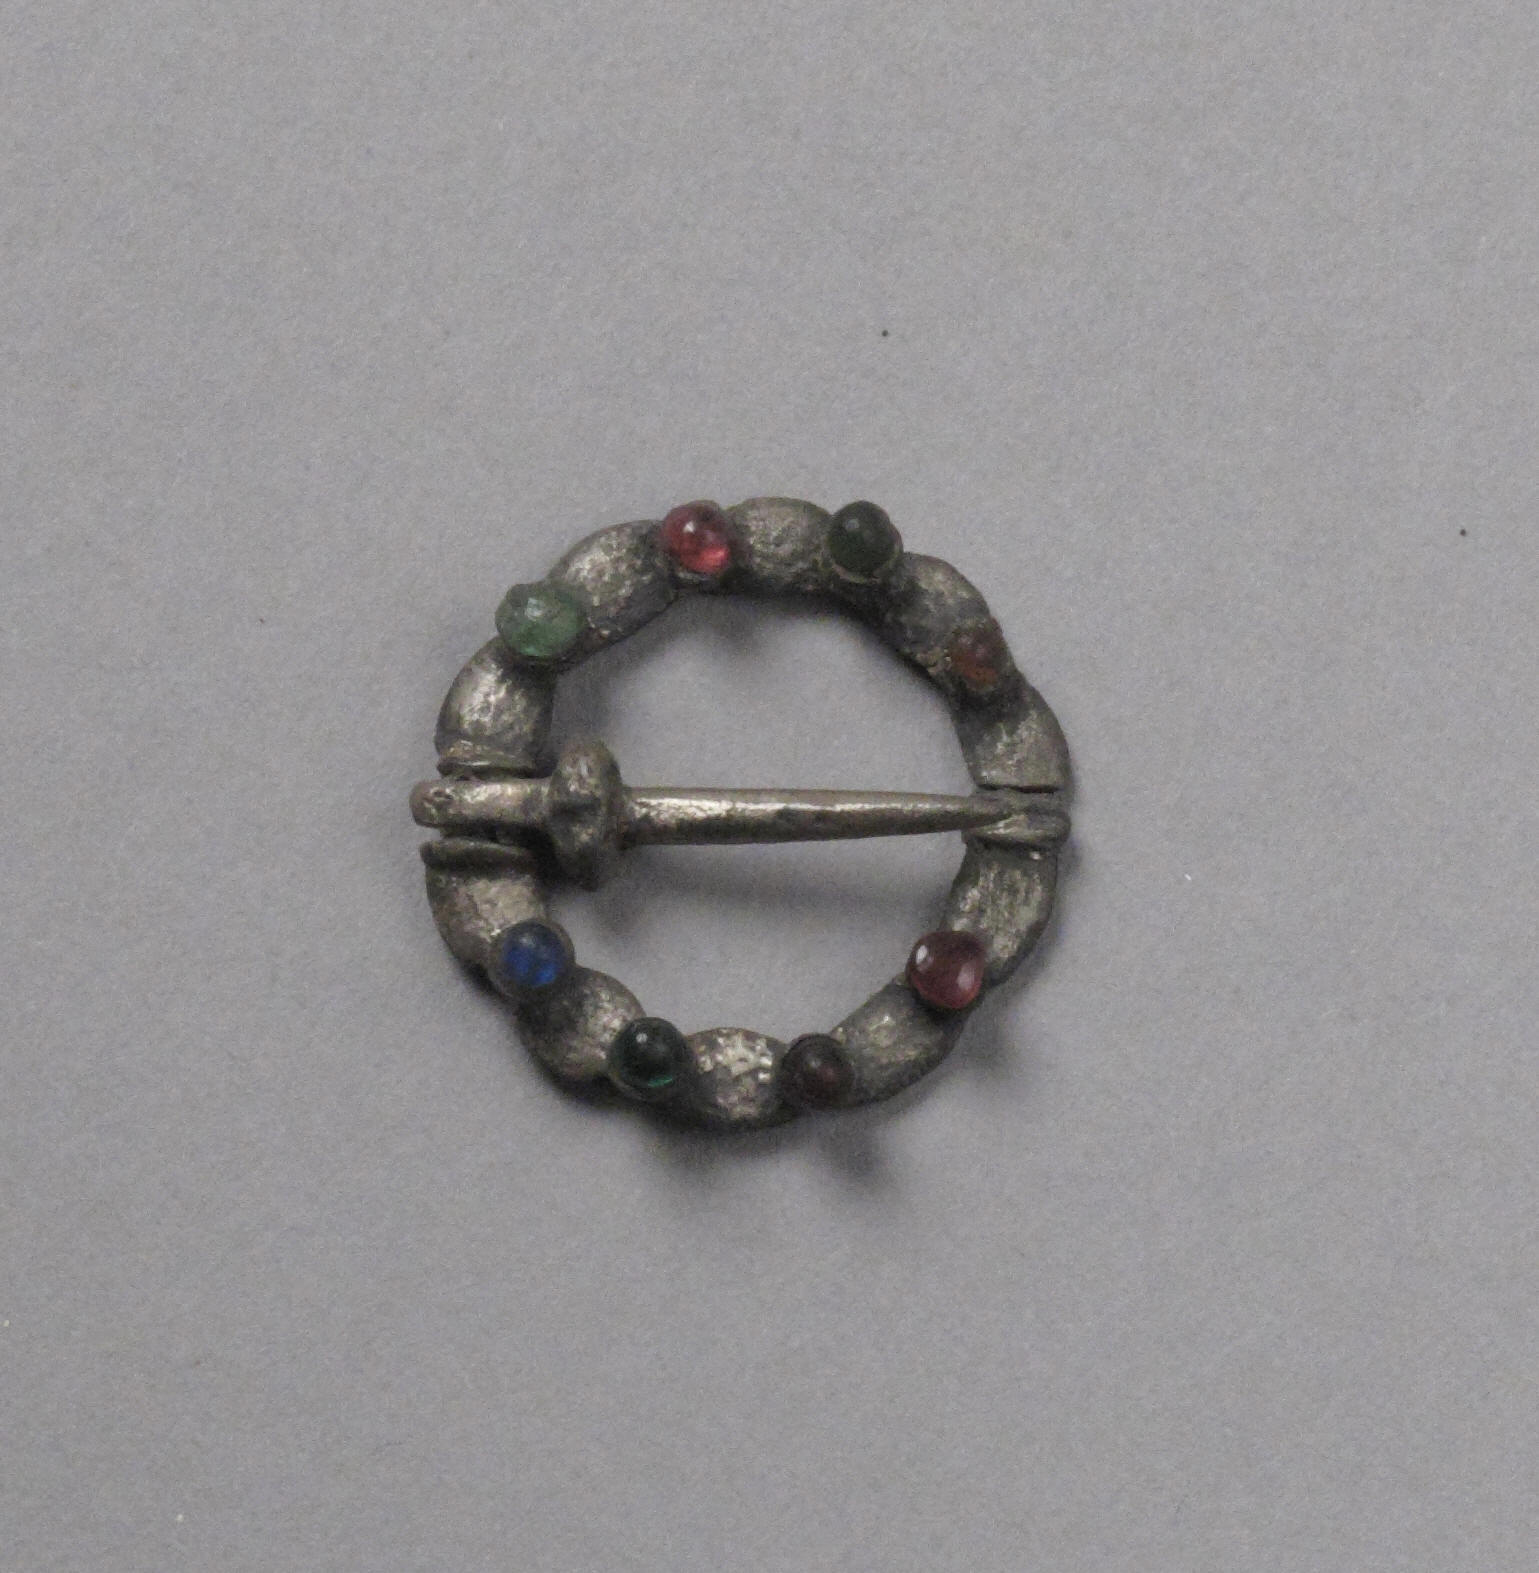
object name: brooch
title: Ring Brooch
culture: british or french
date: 1276-1300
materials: glass, paste, silver